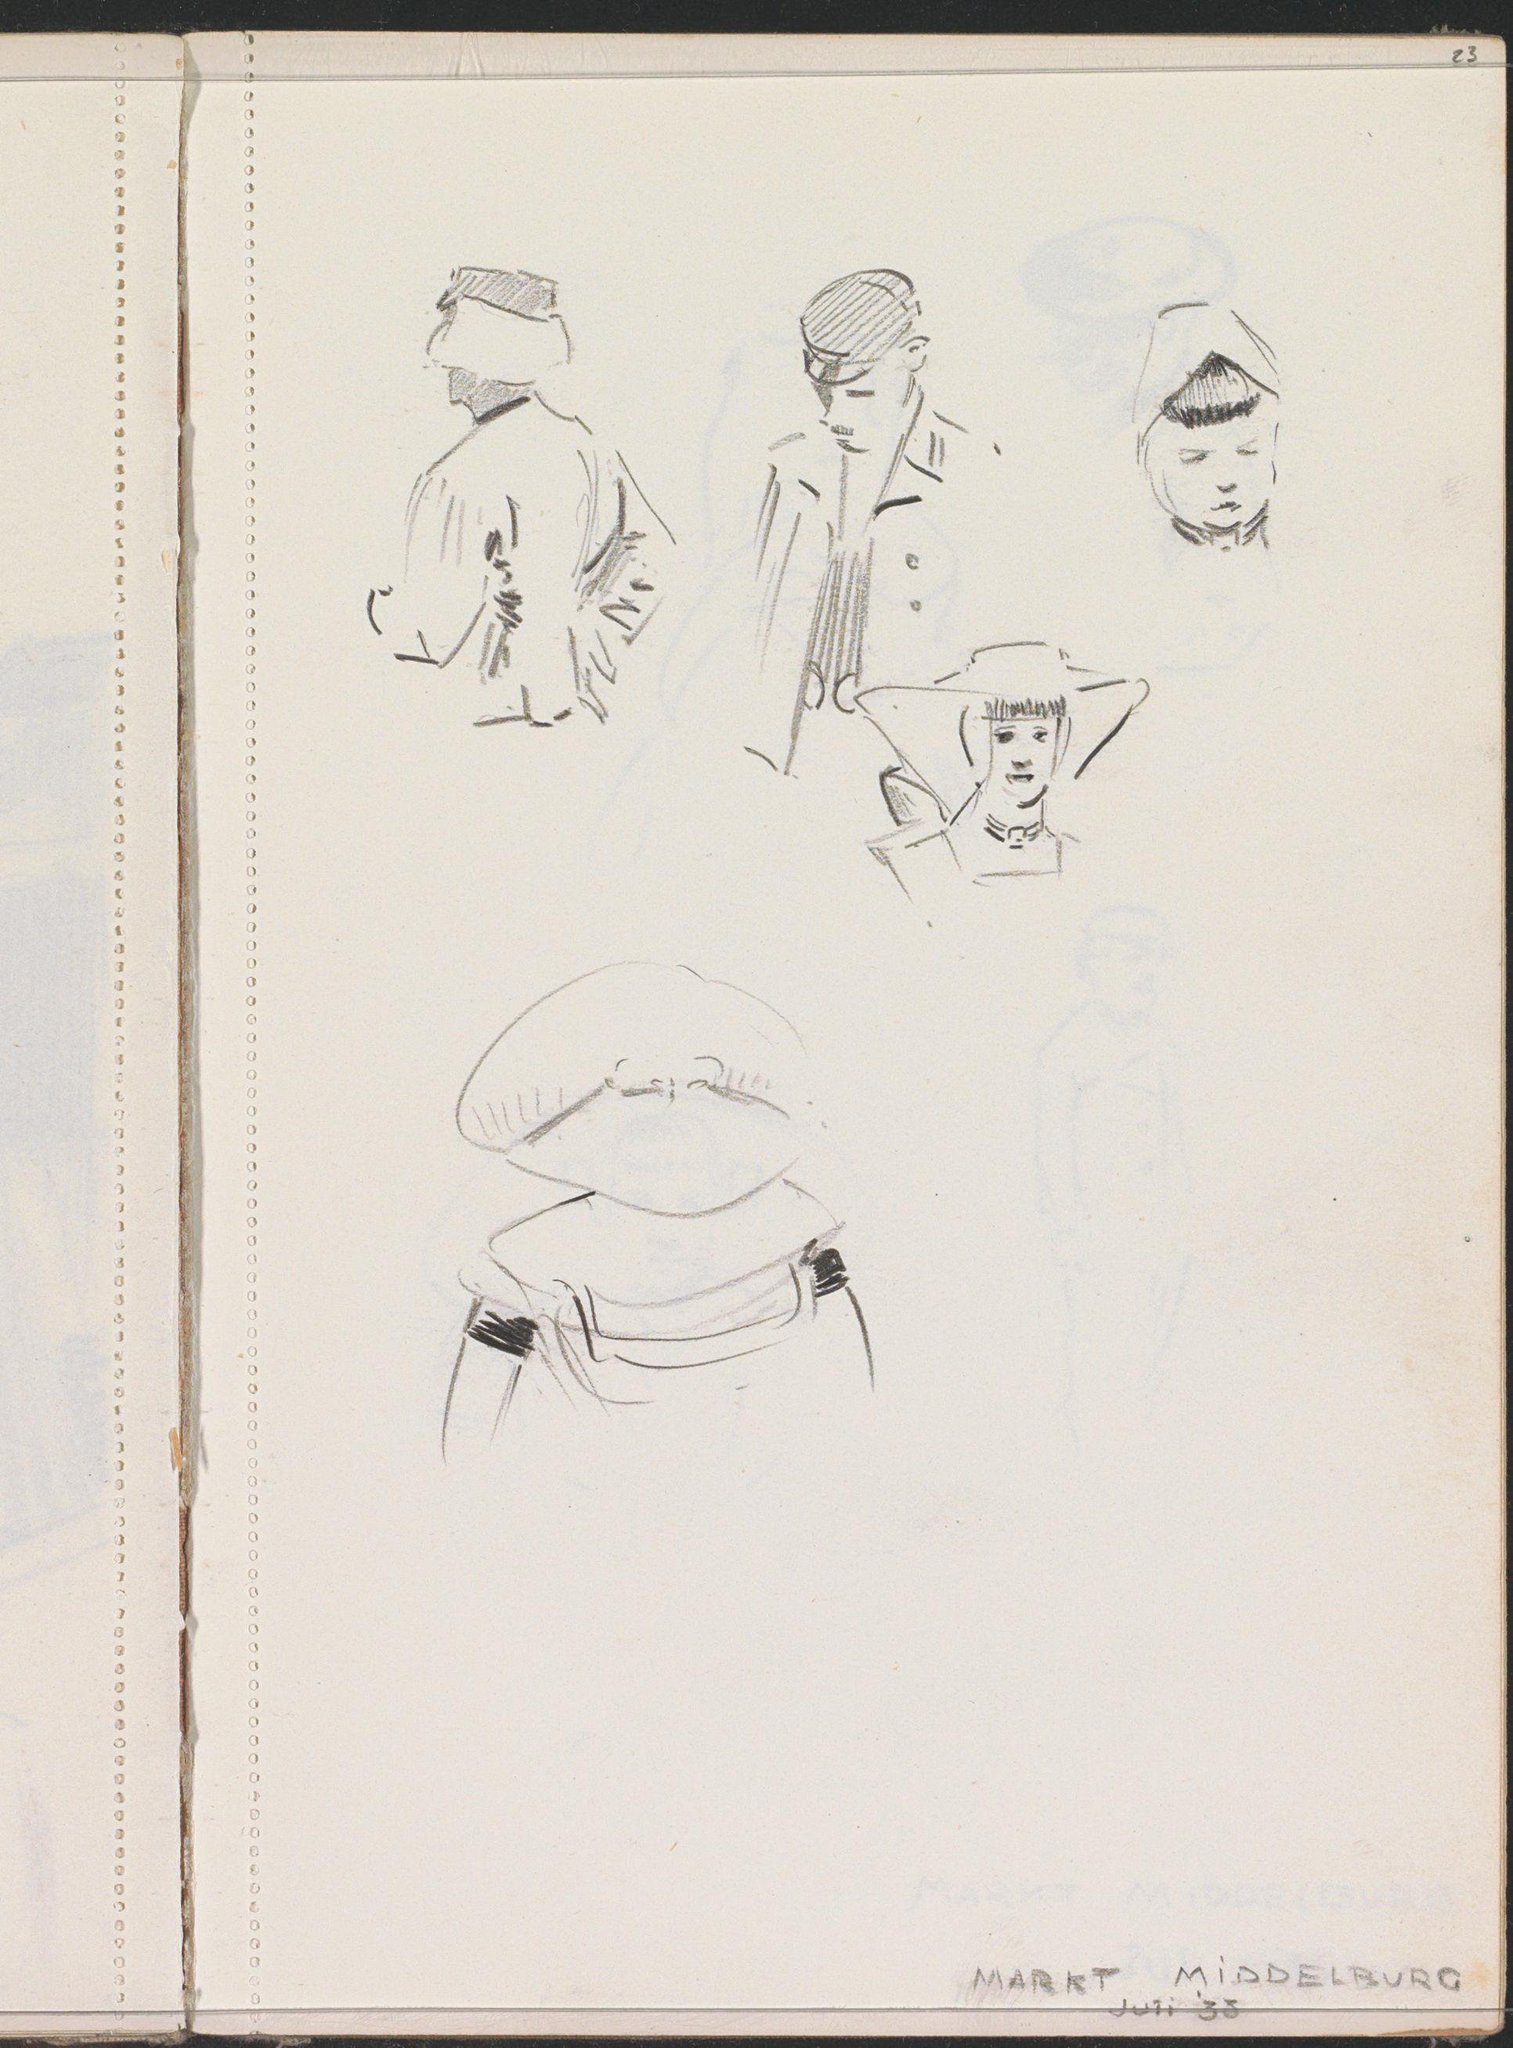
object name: sketchbook leaf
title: Figuren in Zeeuwse klederdracht op de Markt te Middelburg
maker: otto verhagen (i)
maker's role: draughtsman, print maker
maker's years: 1885-1951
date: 1907-1933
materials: chalk, paper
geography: middelburg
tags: folk costume, regional costume, middelburg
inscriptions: date and inscription: ‘MARKT MIDDELBURG/ JULI '33’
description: Pagina 23 uit een schetsboek met 60 bladen.